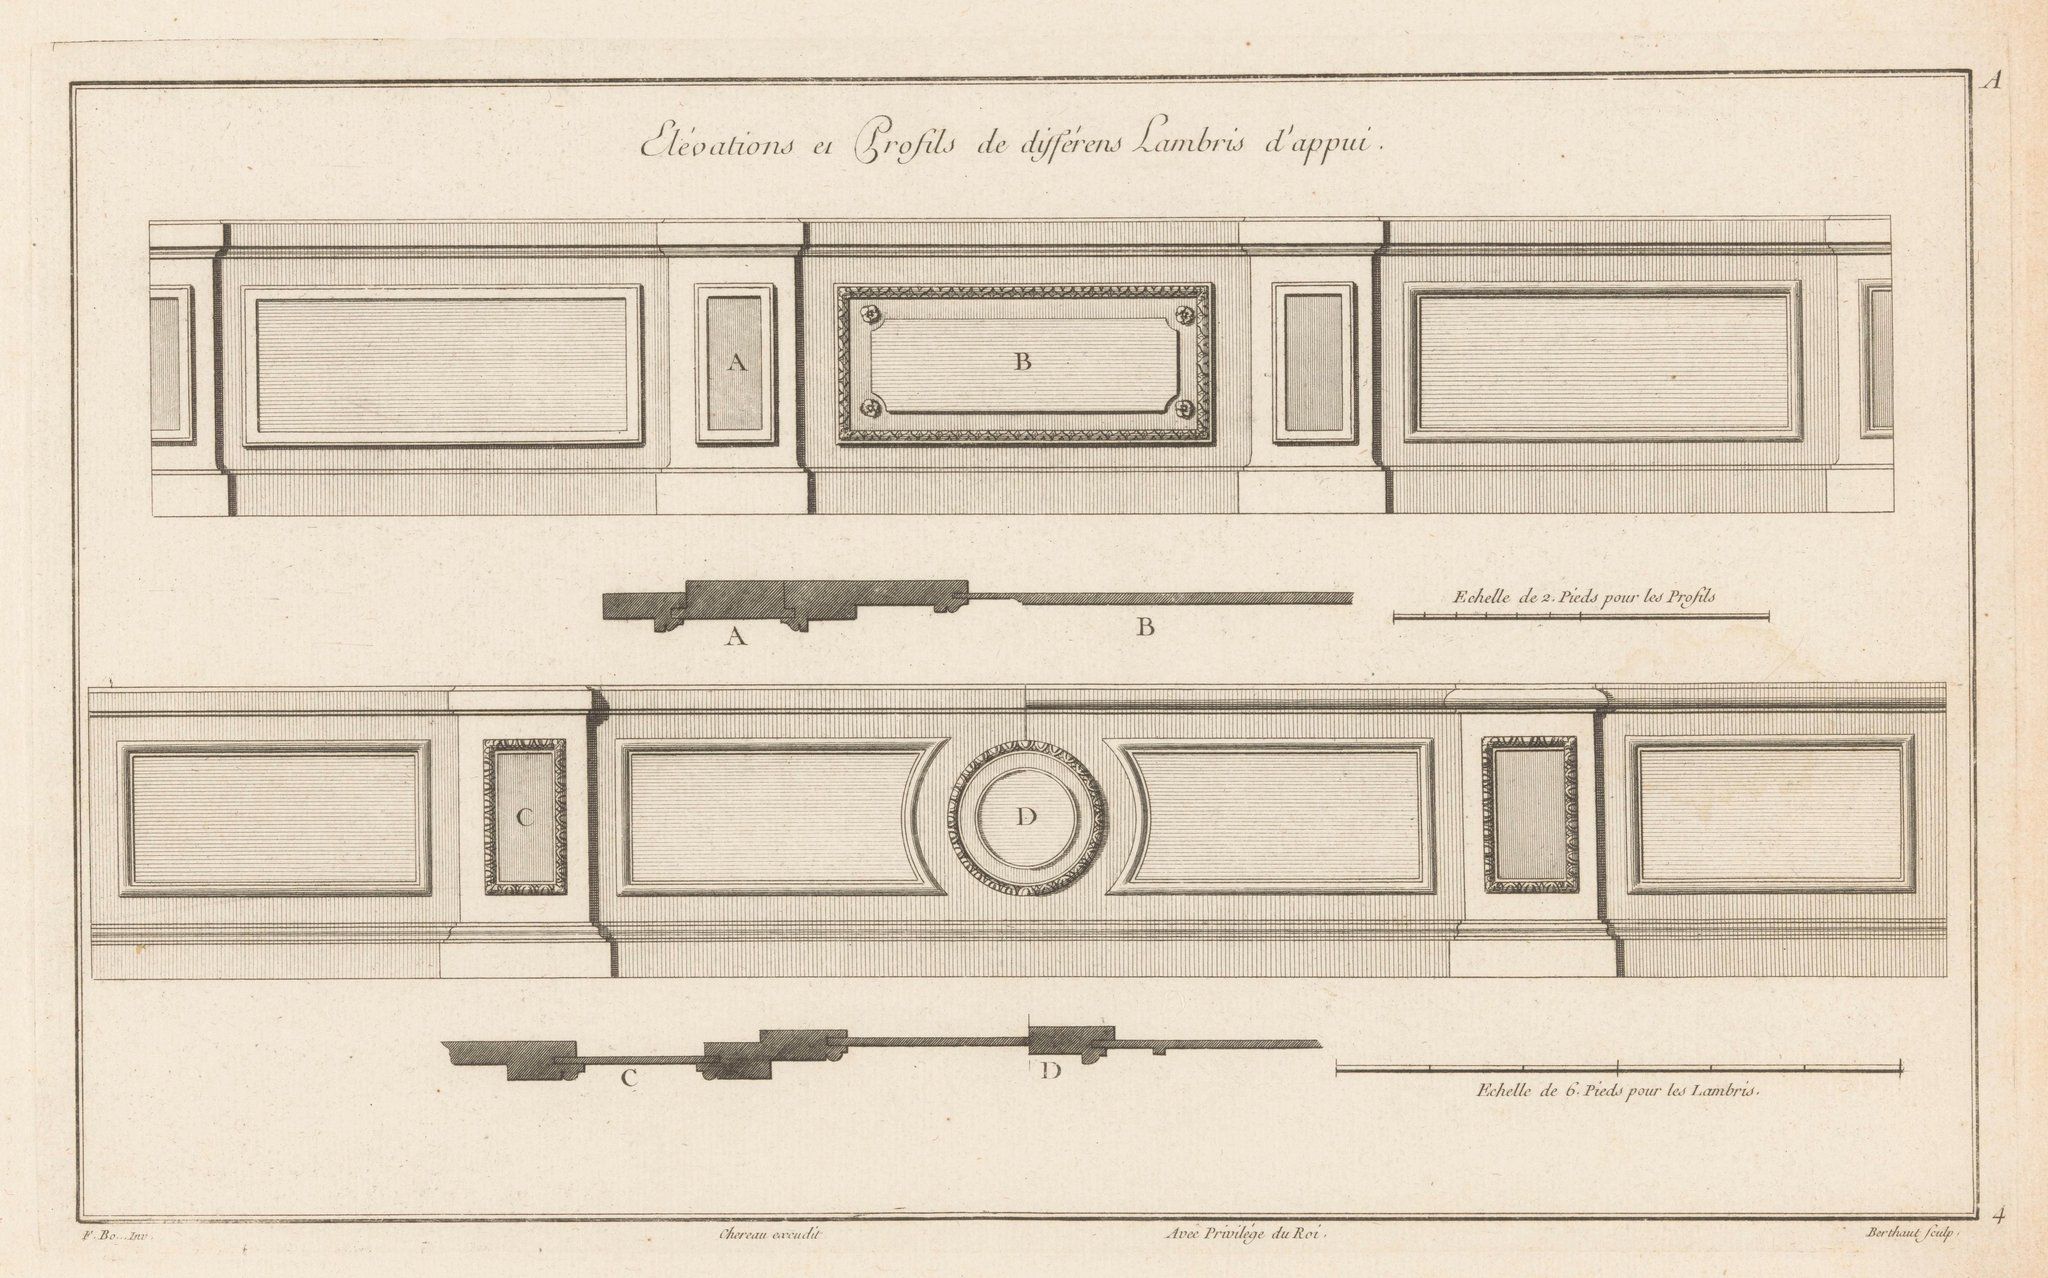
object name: ornament print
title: Twee lambriseringen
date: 1752-1794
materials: paper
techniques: engraving, etching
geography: paris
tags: panelling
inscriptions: collector's mark: Lugt 2760, collector's mark: Lugt 2228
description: Ontwerpen en profielen van twee lambriseringen.